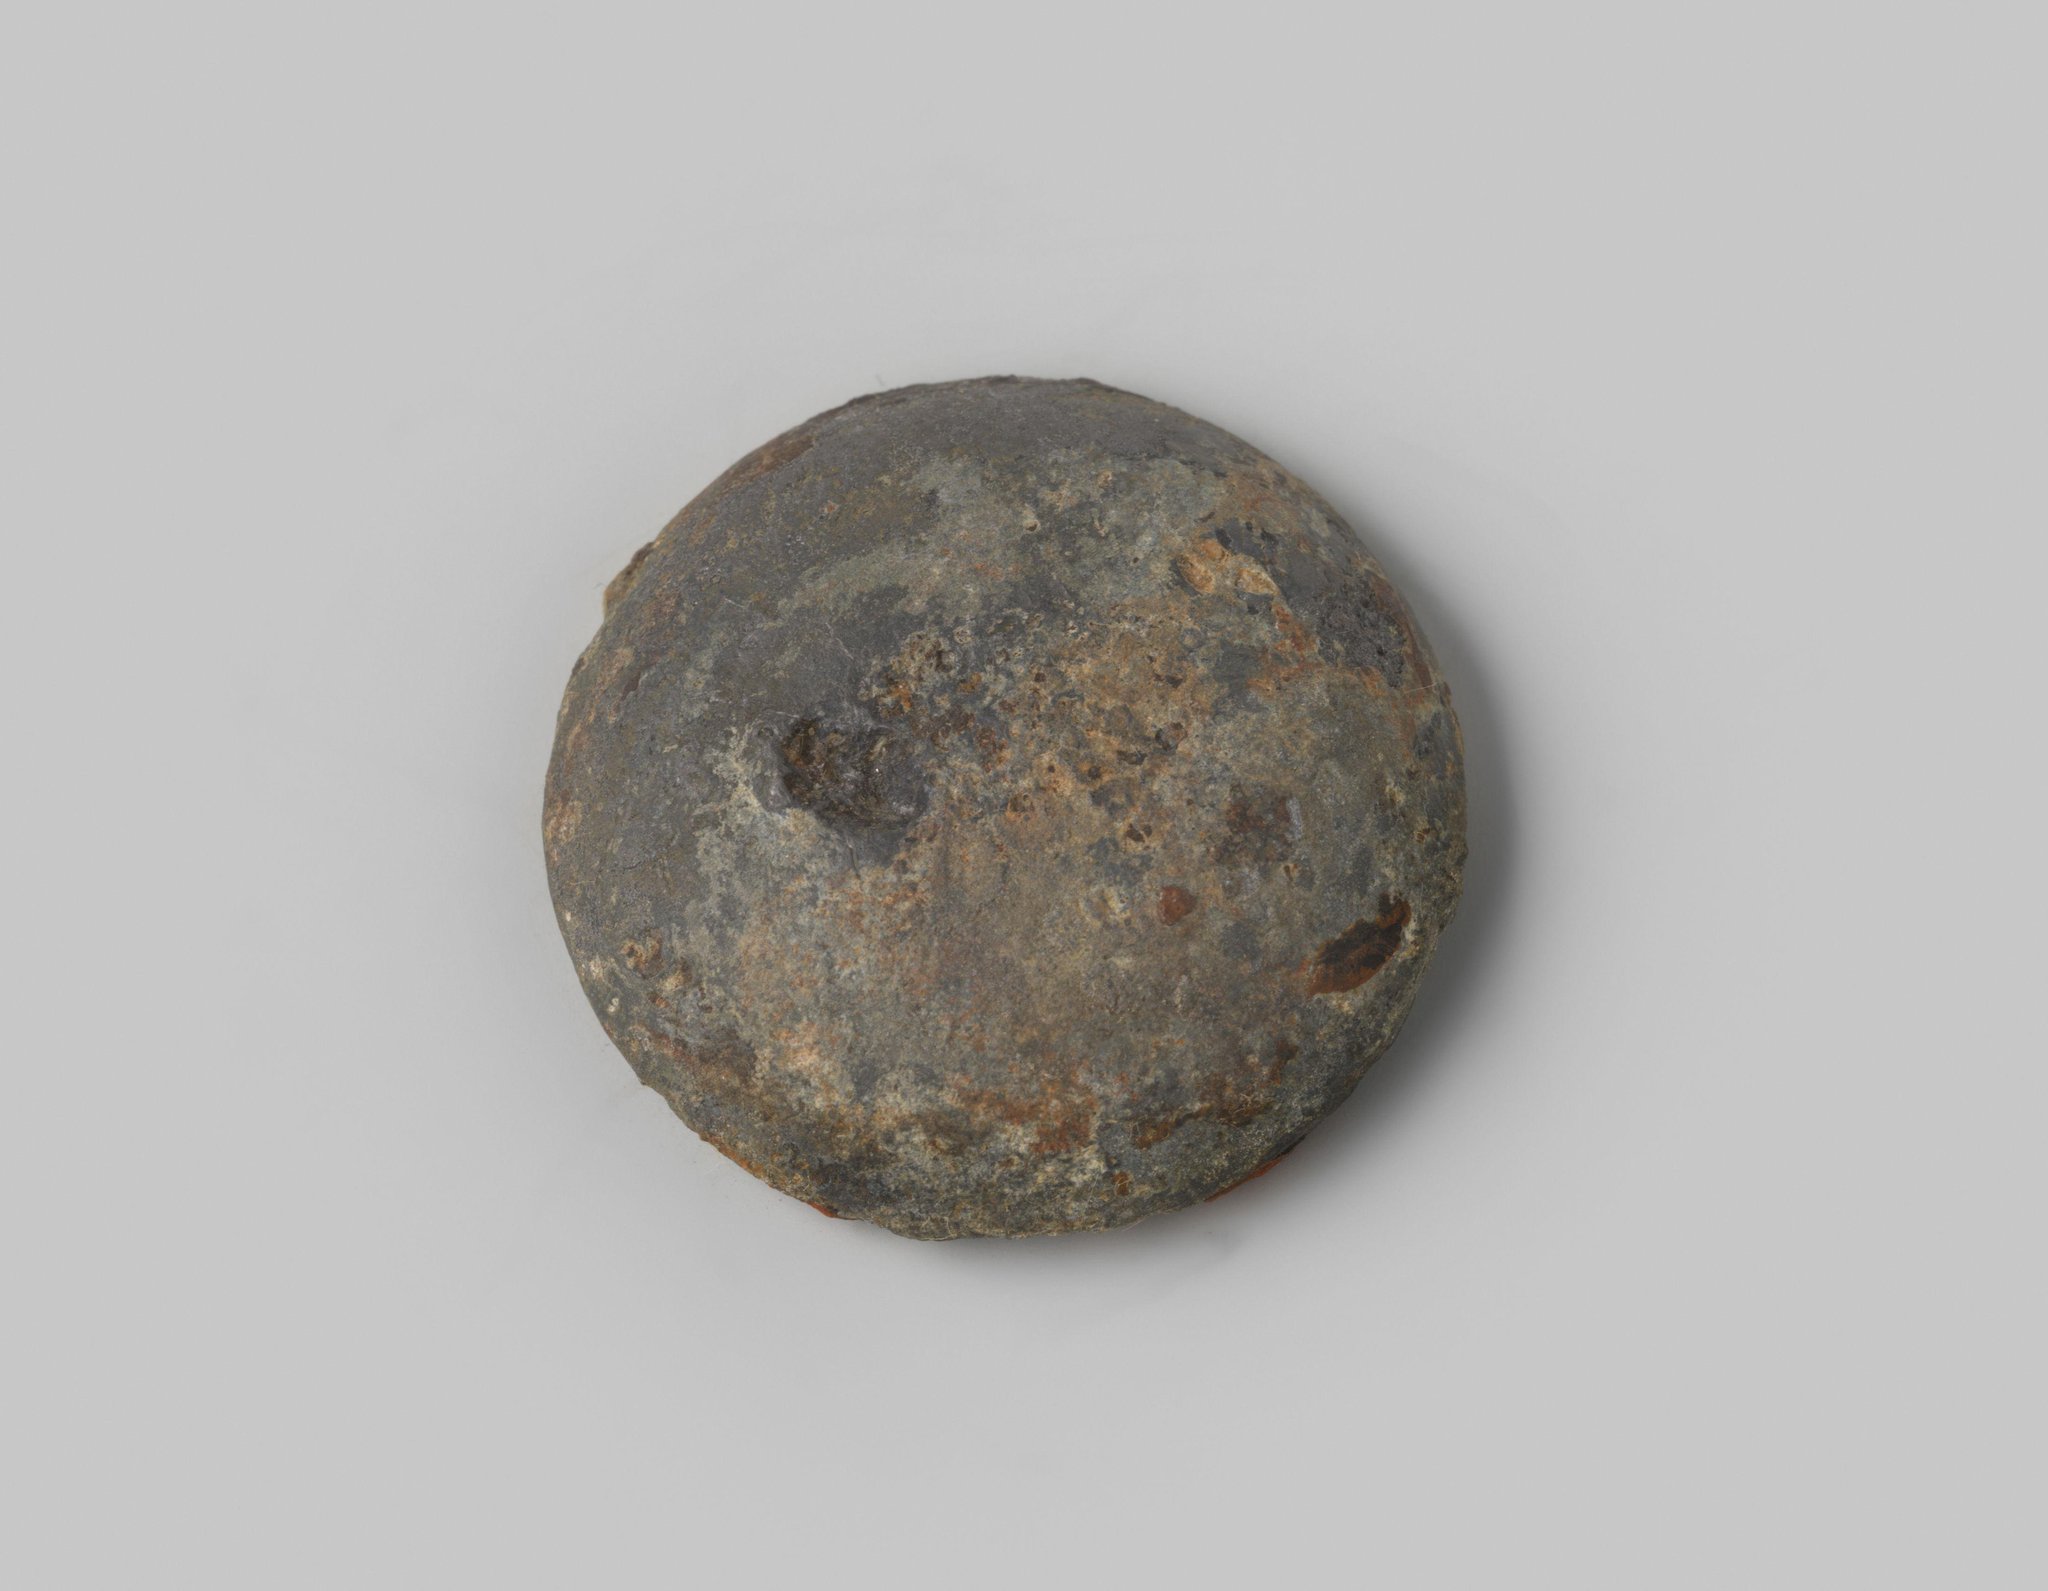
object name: weight scale component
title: Gewicht uit het wrak van de Oost-Indiëvaarder Hollandia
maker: Anonymous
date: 1700-1743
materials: lead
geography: netherlands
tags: verenigde oostindische compagnie, hollandia (schip), annet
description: Disc-shaped weight, sim. NG 1980-27H2928.